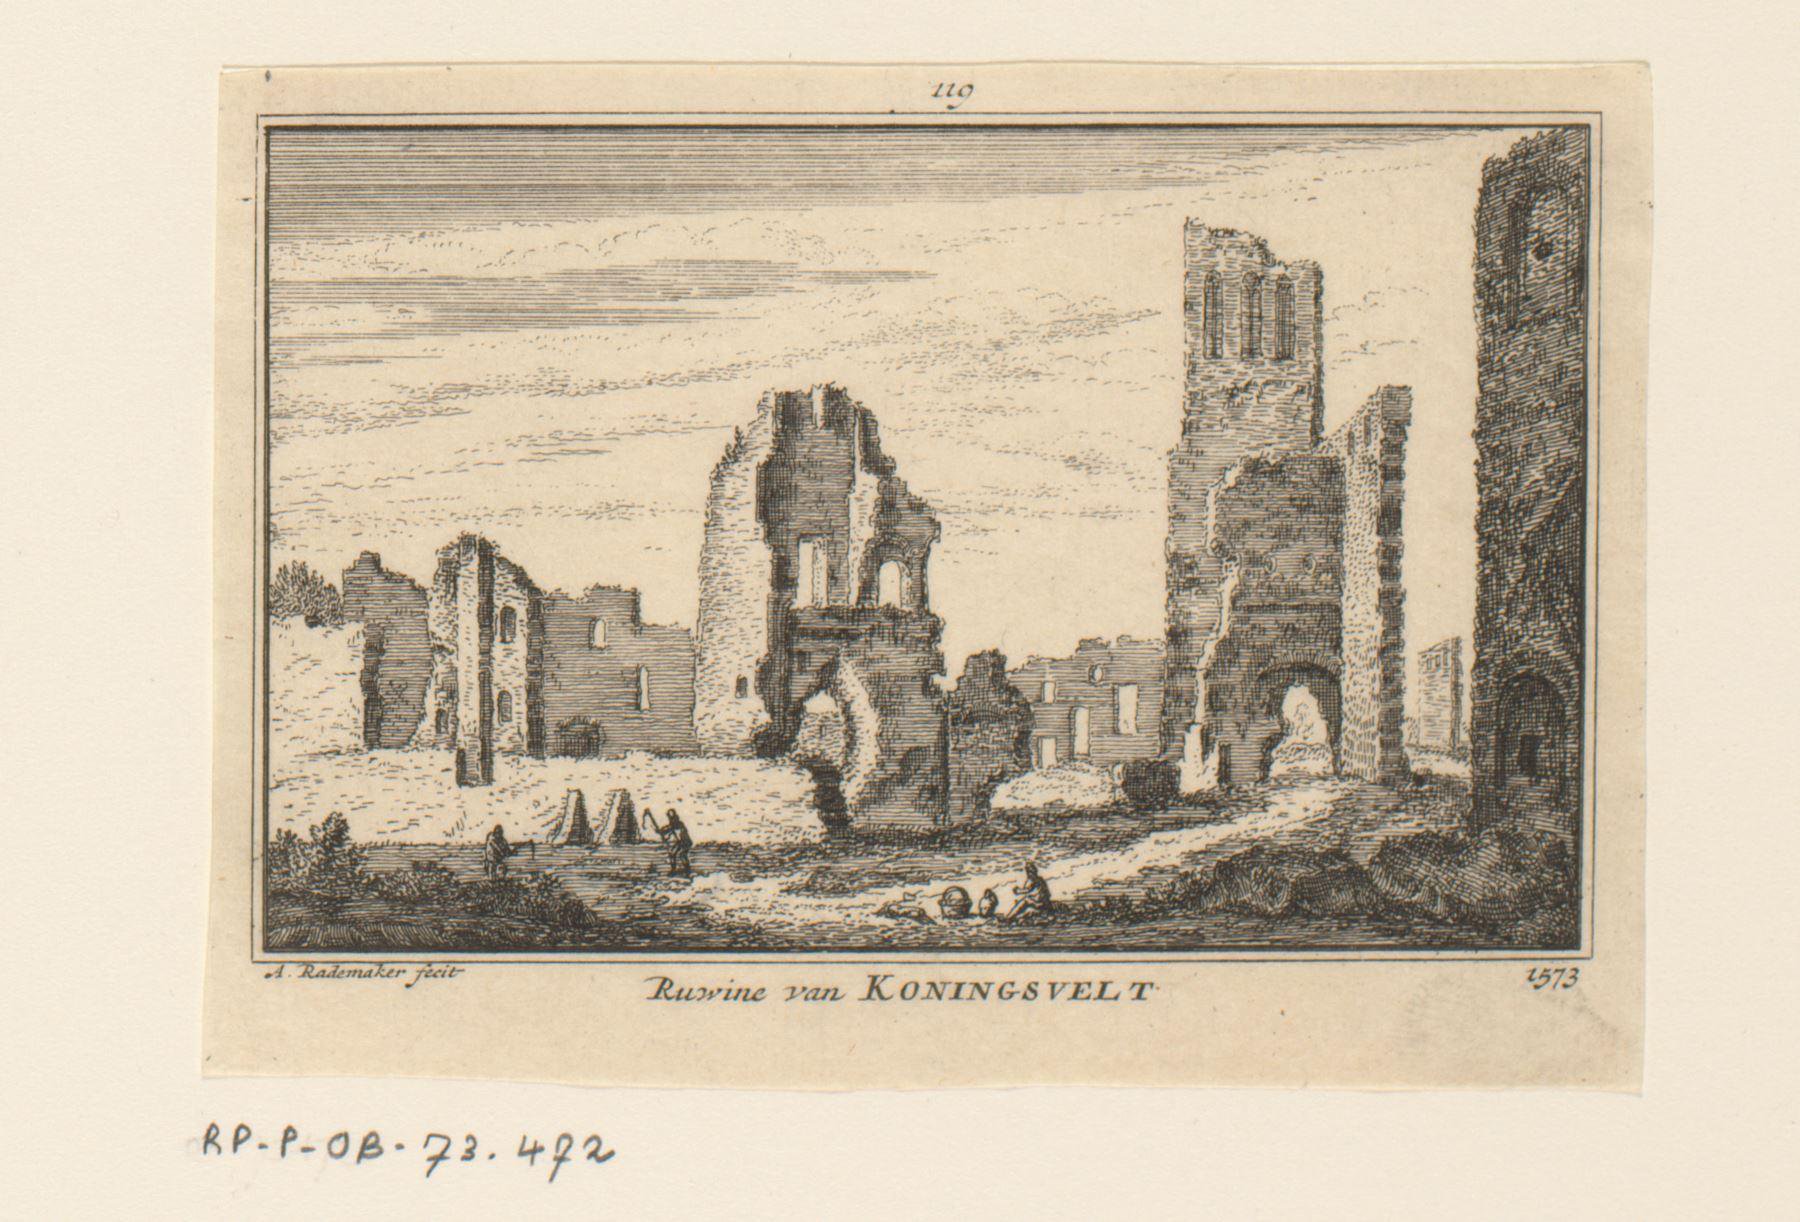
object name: book illustration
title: Ruwine van Koningsvelt 1573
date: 1727-1733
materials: paper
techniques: etching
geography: amsterdam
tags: ruin of church, monastery, etc., fisherman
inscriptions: collector's mark: Lugt 2228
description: Illustratie uit: Abraham Rademaker, Matthaeus Brouërius van Niedek, Isaac Le Long, Kabinet van Nederlandsche en Kleefsche outheden en (...) voorname stads- en landgebouwen, Willem Barents en Antoni Schoonenburg: Amsterdam, 1727-1733, ill. nr. 107.